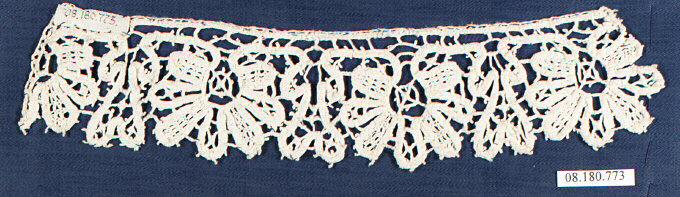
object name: fragment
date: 1601-1700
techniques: lace